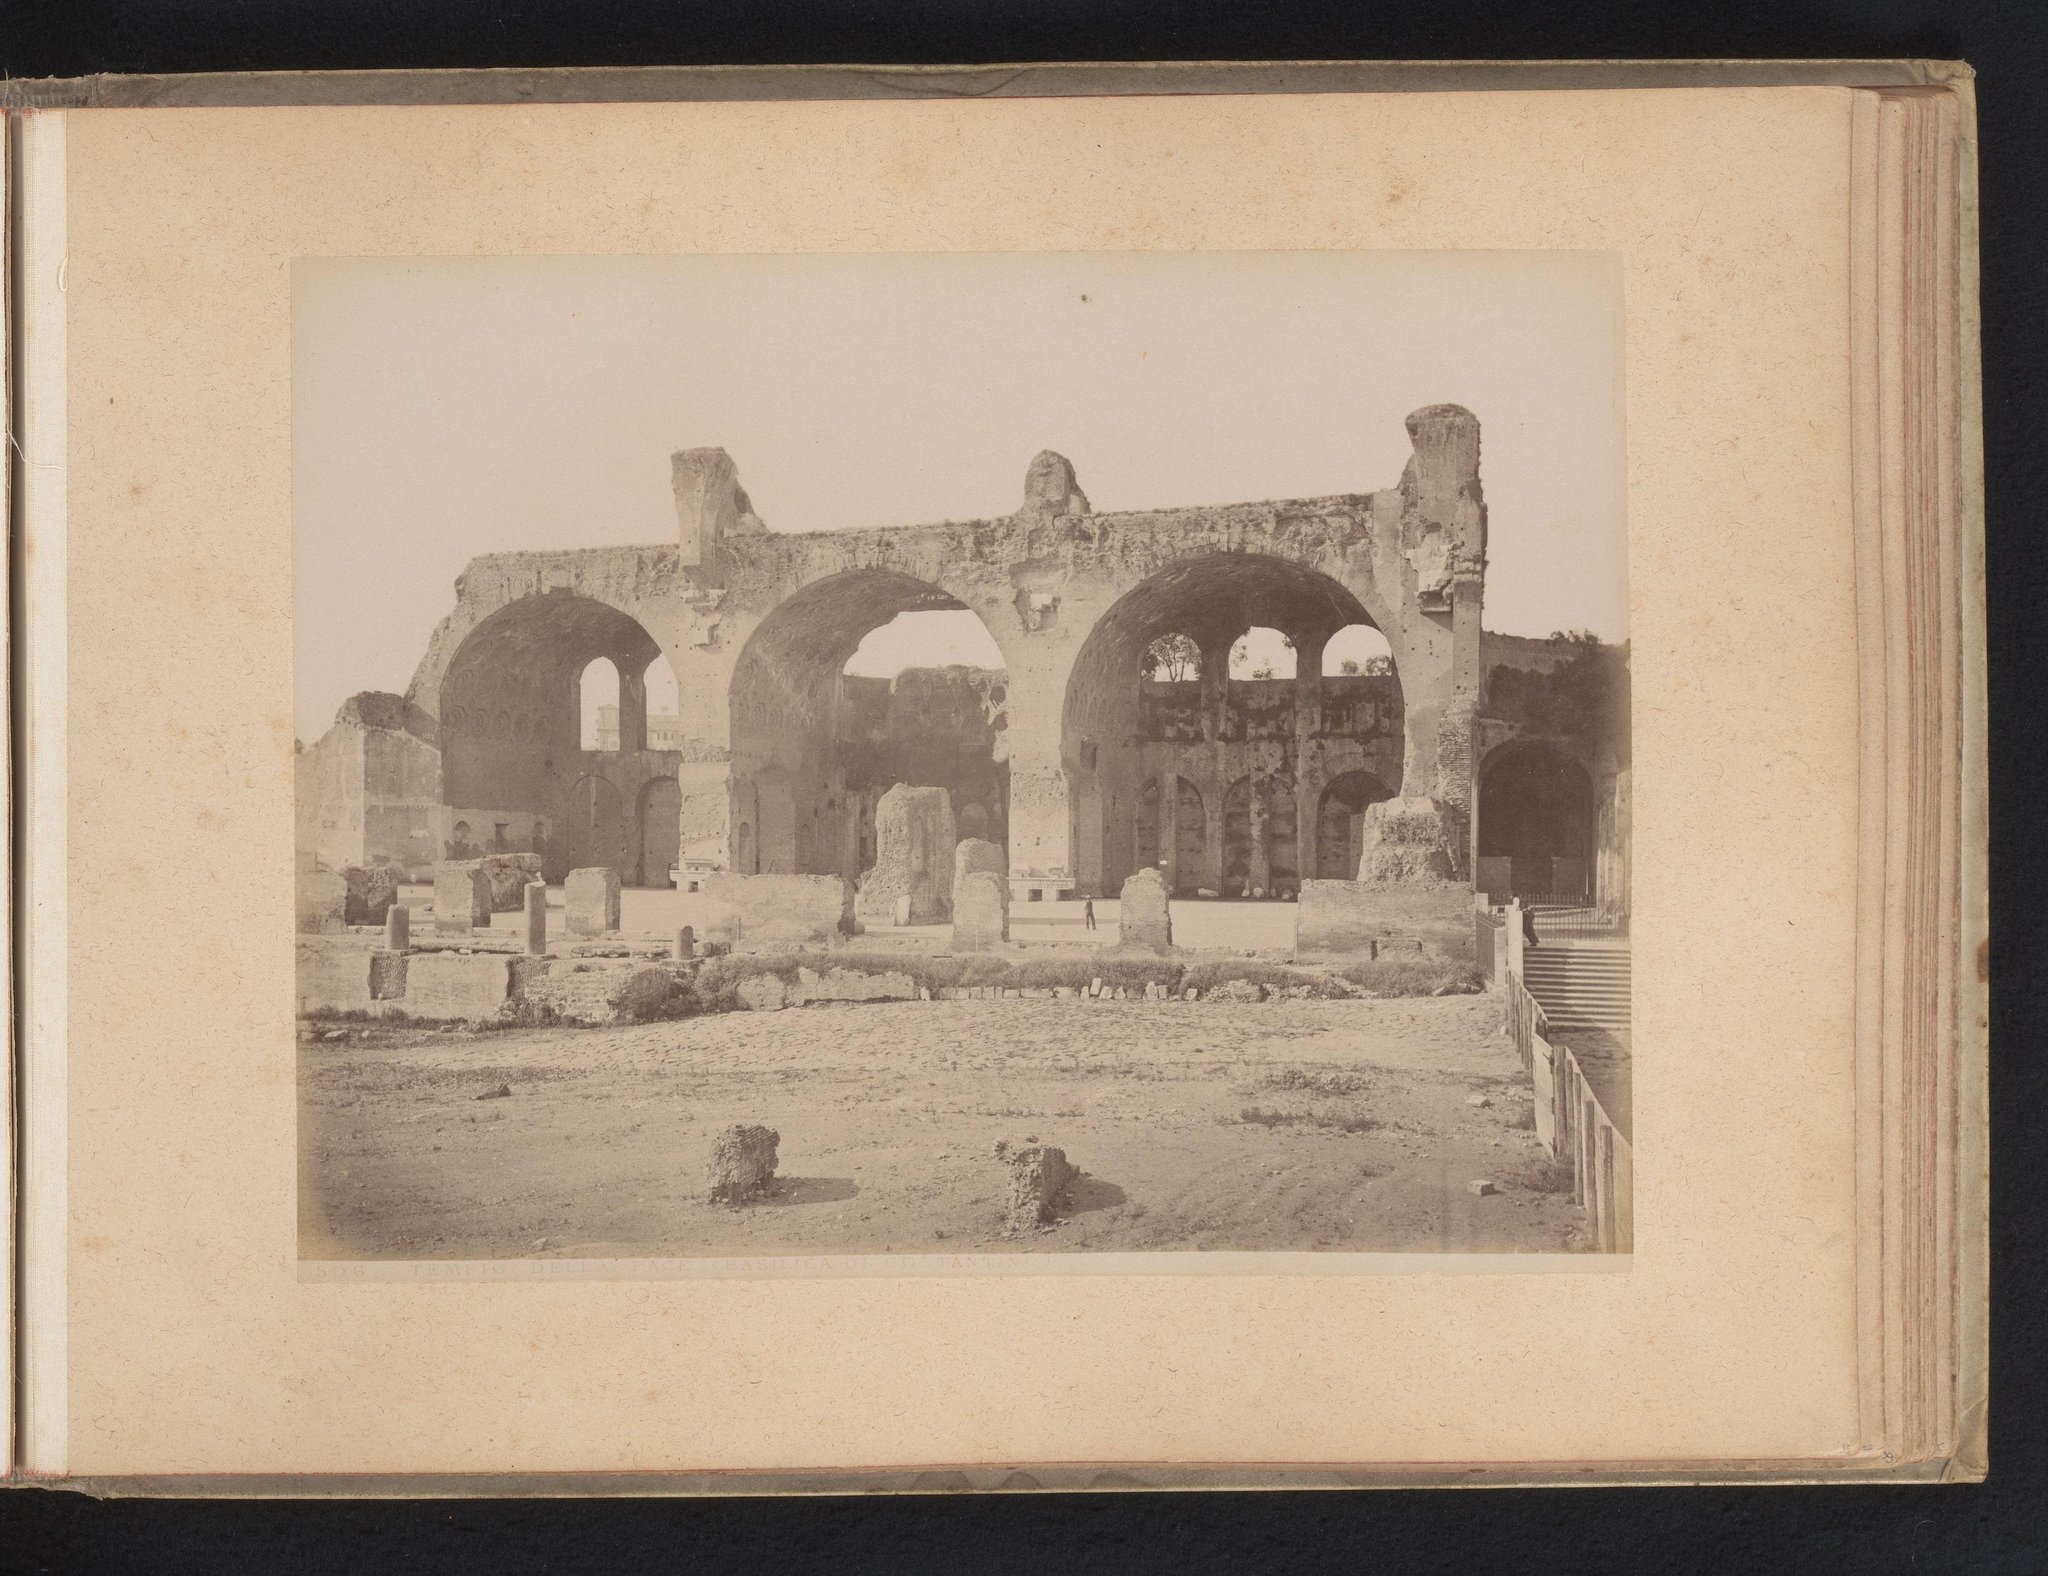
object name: photograph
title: Gezicht op de Vredestempel op het Forum Romanum in Rome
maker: Anonymous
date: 1870-1895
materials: cardboard, photographic support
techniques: albumen print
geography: rome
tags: symbols, allegories of peace, 'pax'; 'pace' (ripa), ruin of a building ~ architecture, temple, shrine ~ roman religion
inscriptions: inscription: ‘506 TEMPLO DELLA PACE BASILICA DI CONSTANTINO’